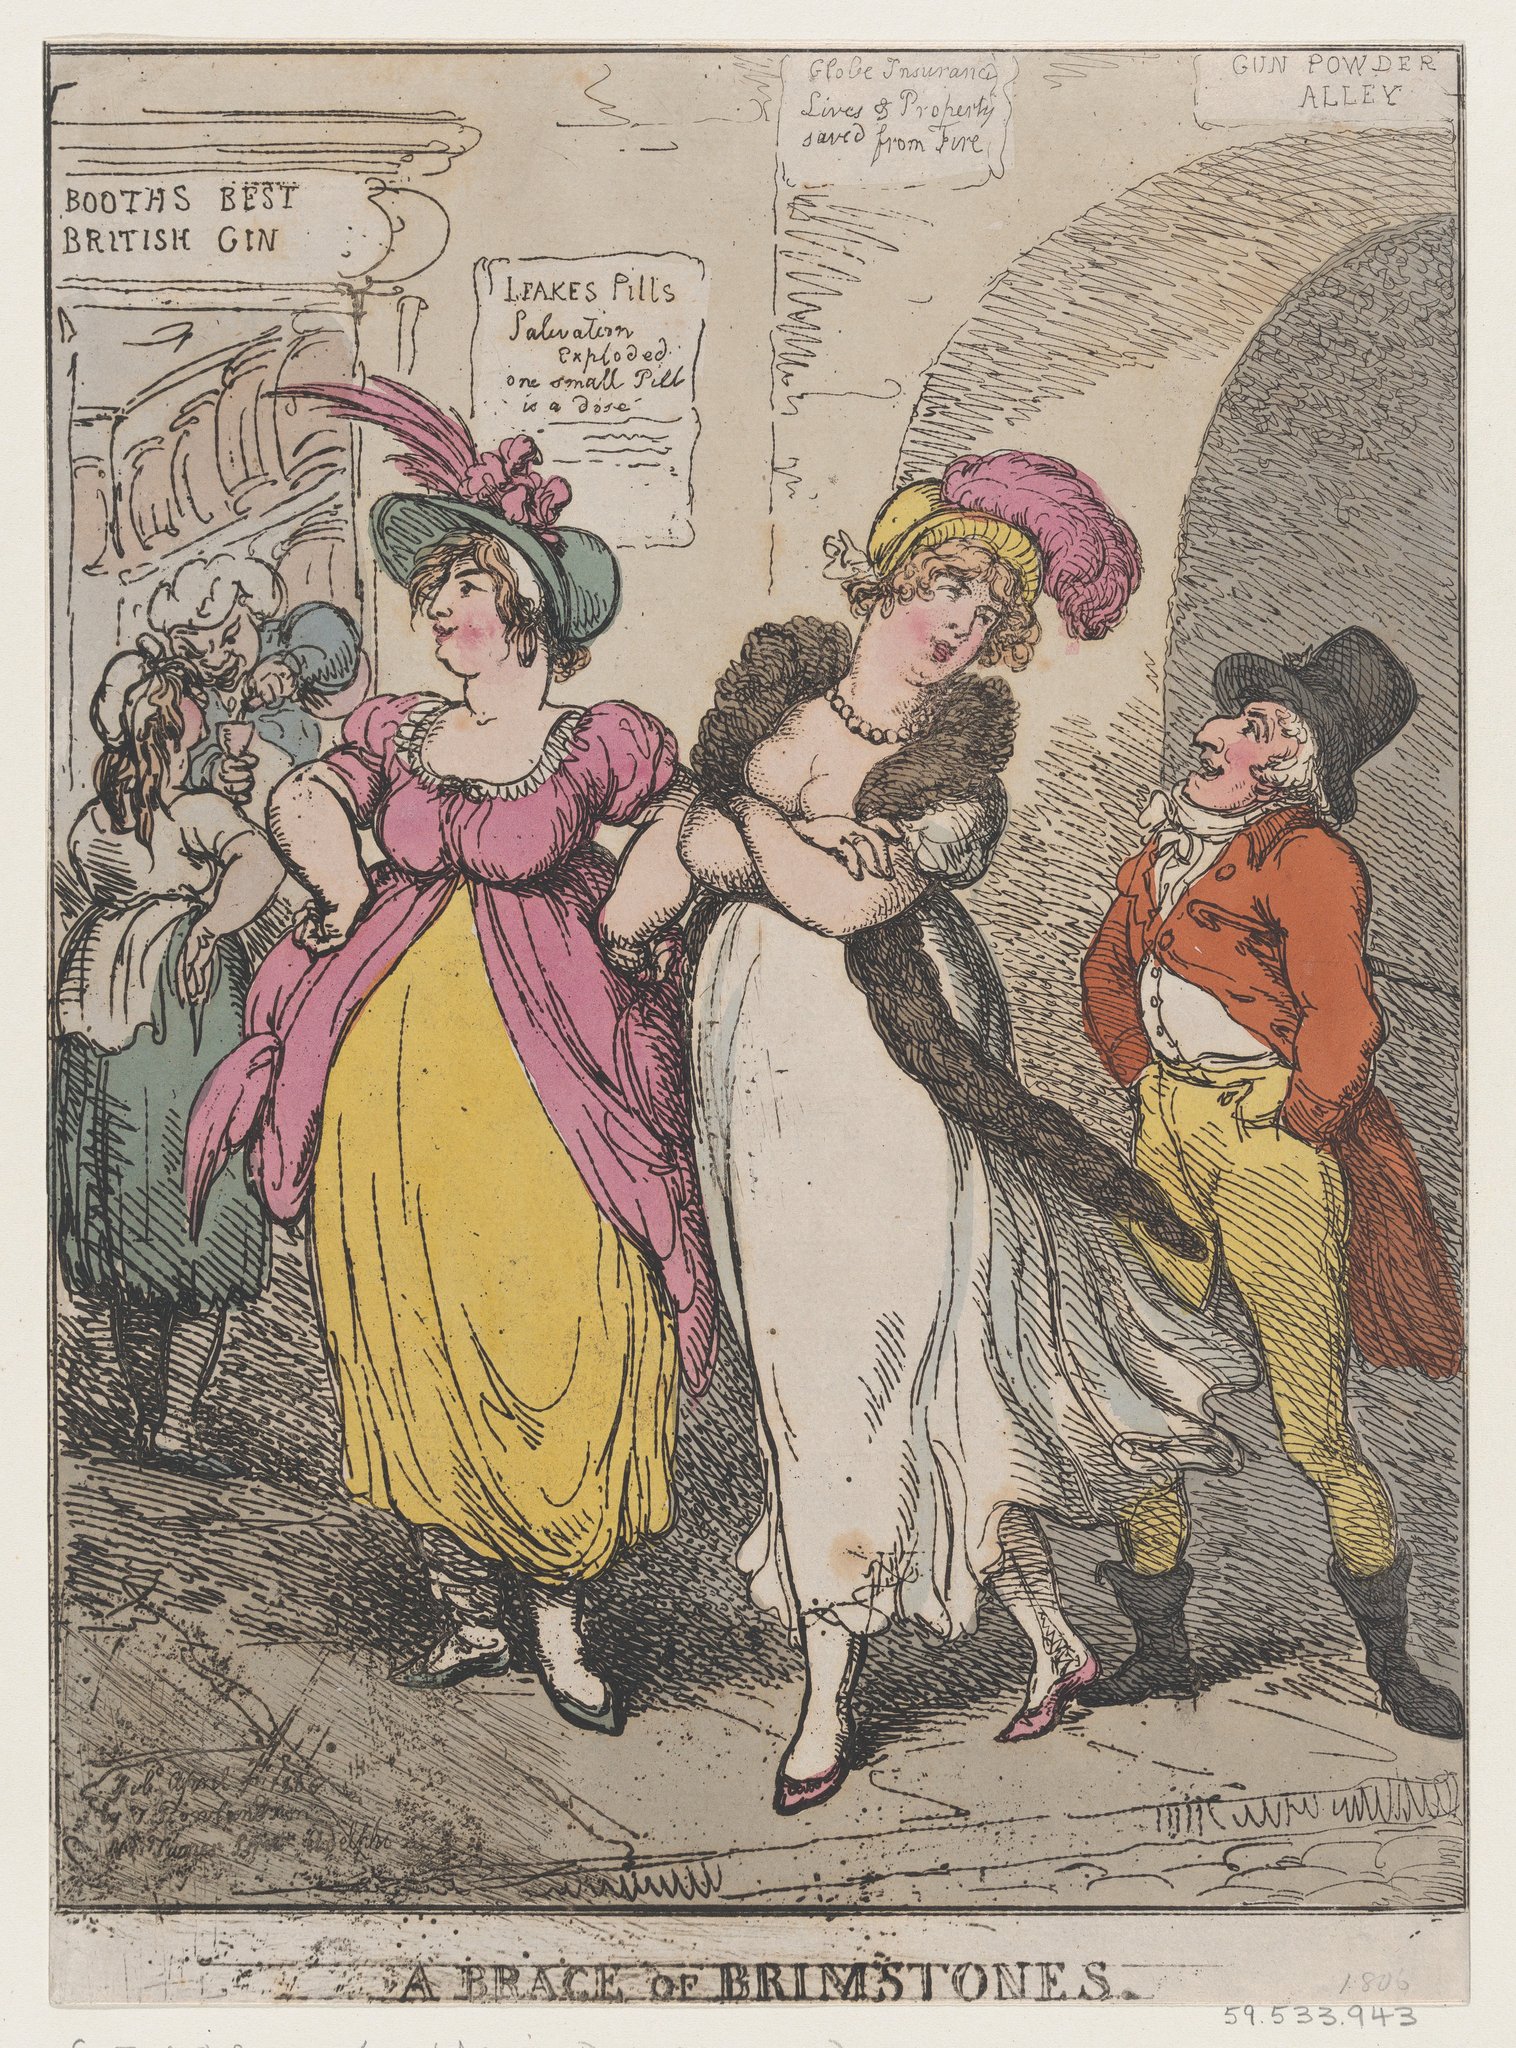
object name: print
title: A Brace of Brimstones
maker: thomas rowlandson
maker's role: artist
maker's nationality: british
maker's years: 1757-1827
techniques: etching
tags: satire,men,women